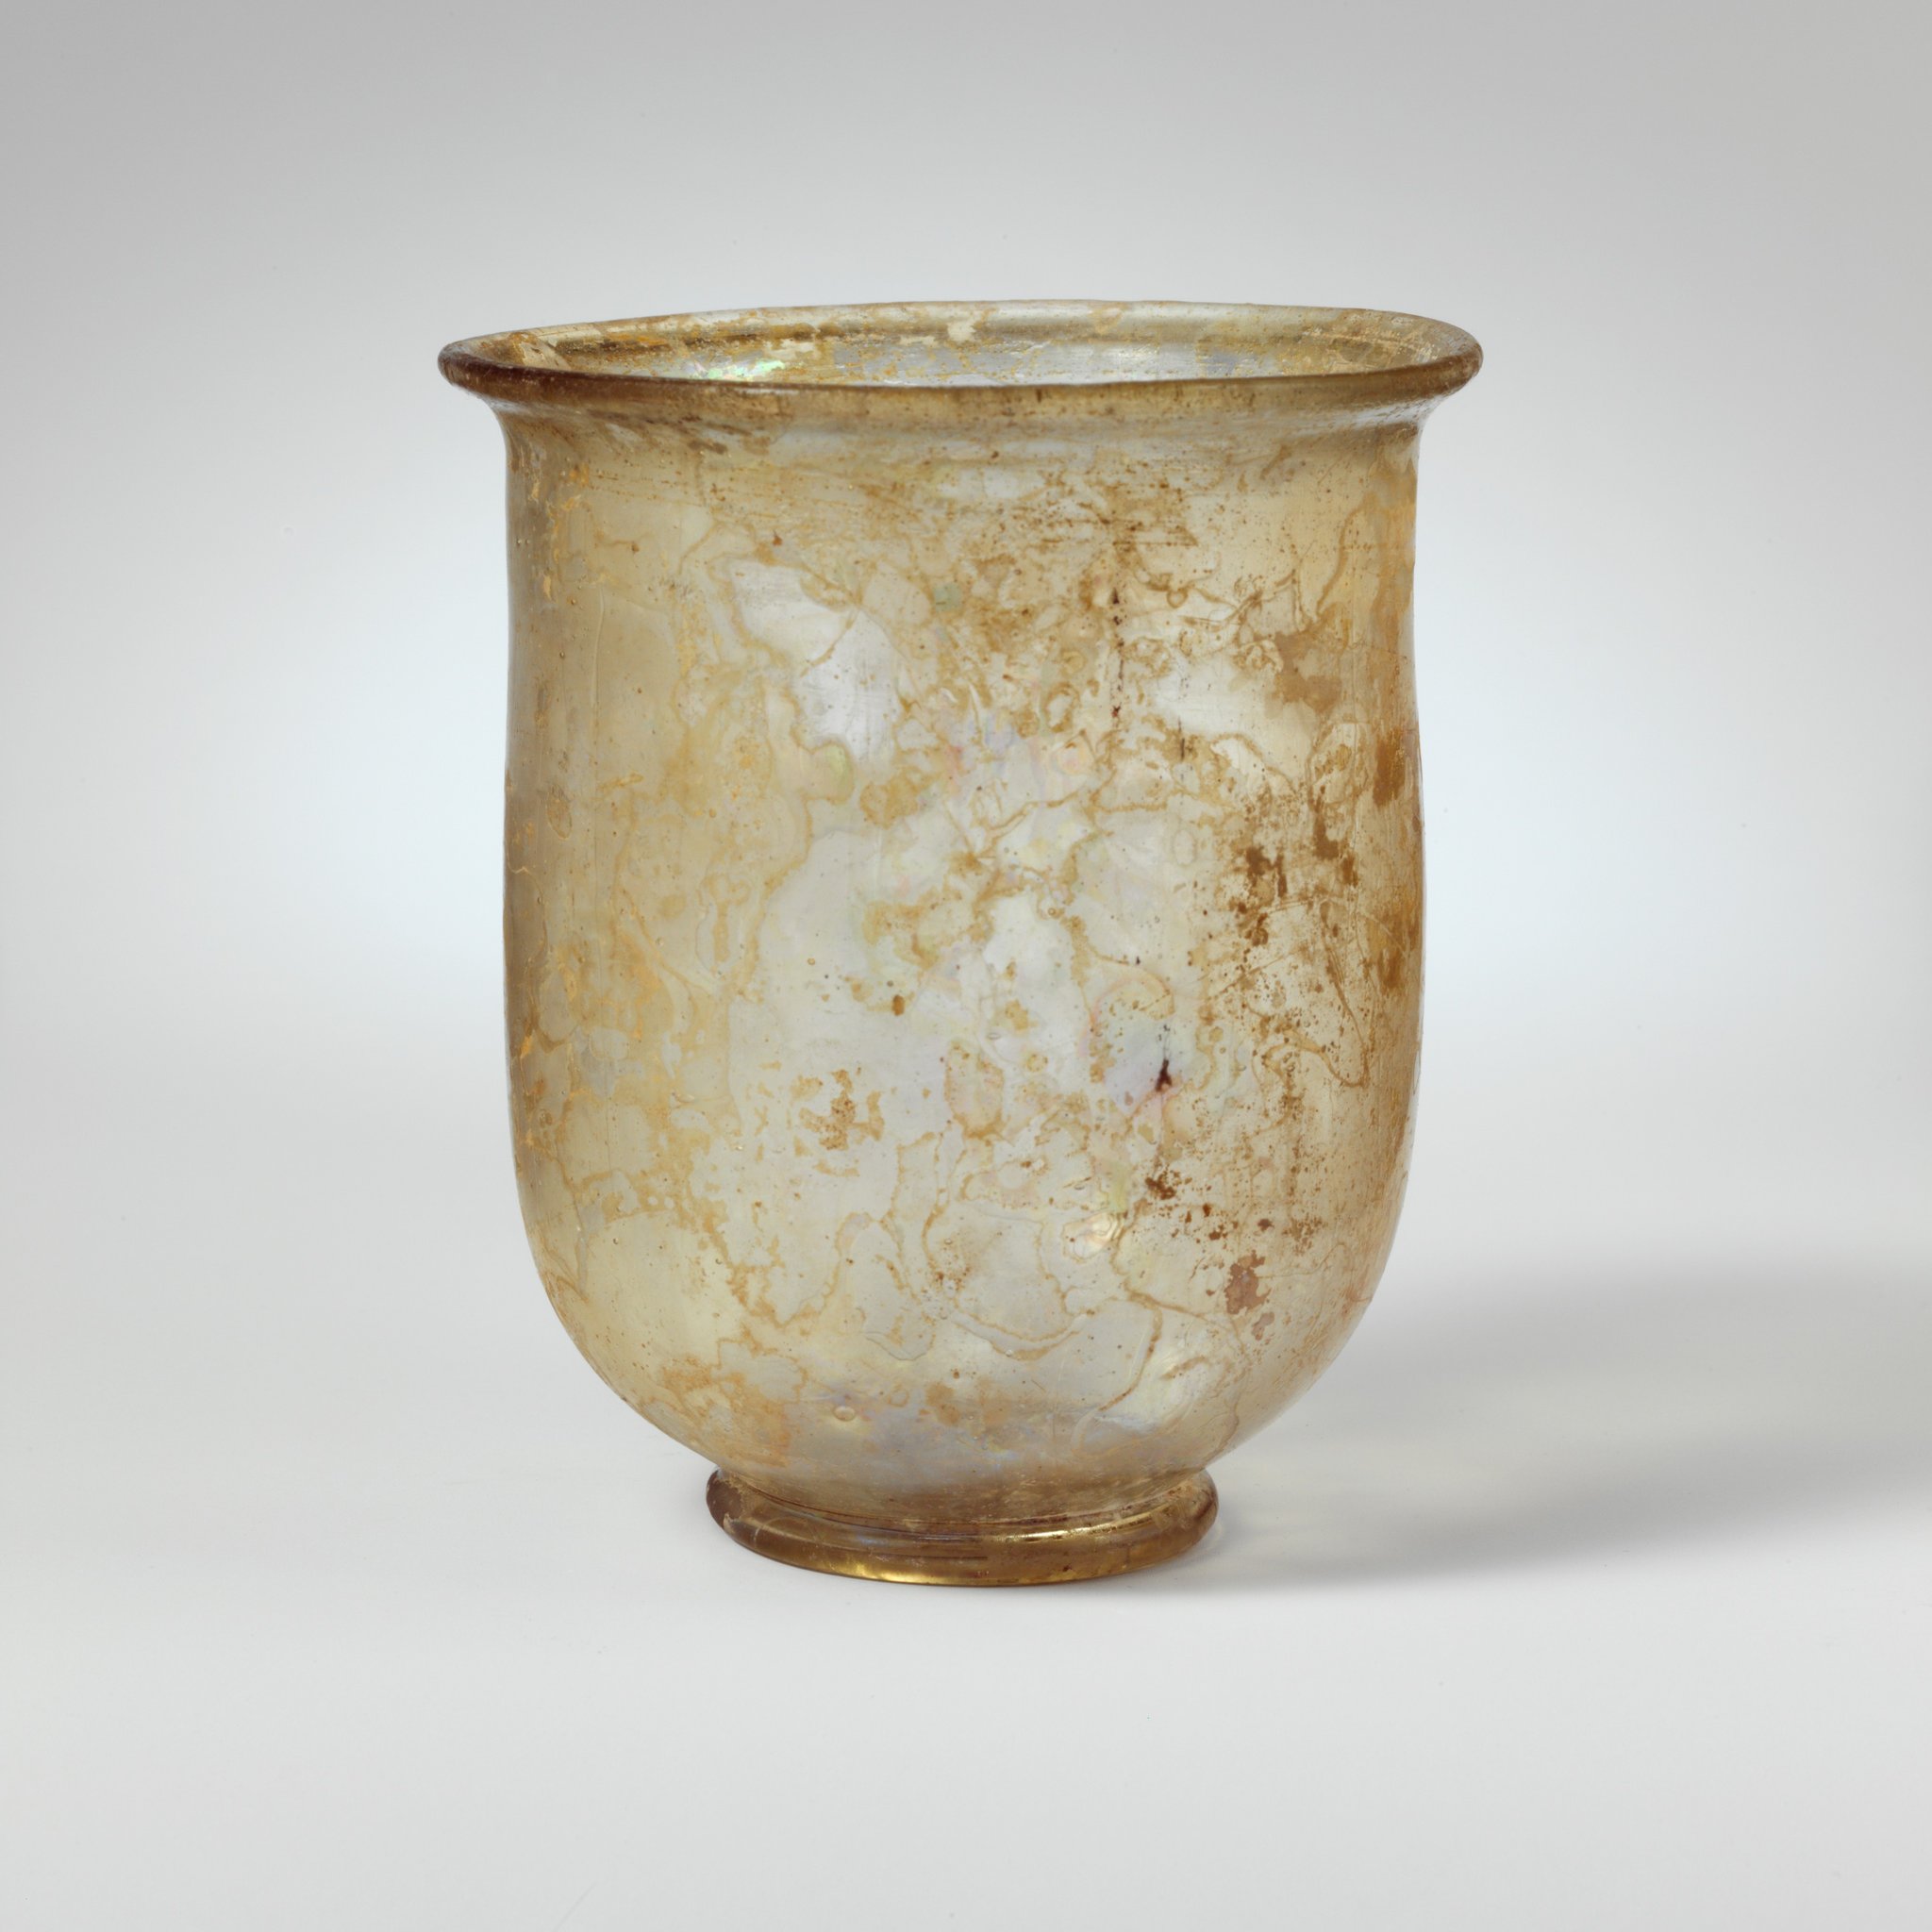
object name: beaker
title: Glass beaker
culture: roman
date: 101-300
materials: glass